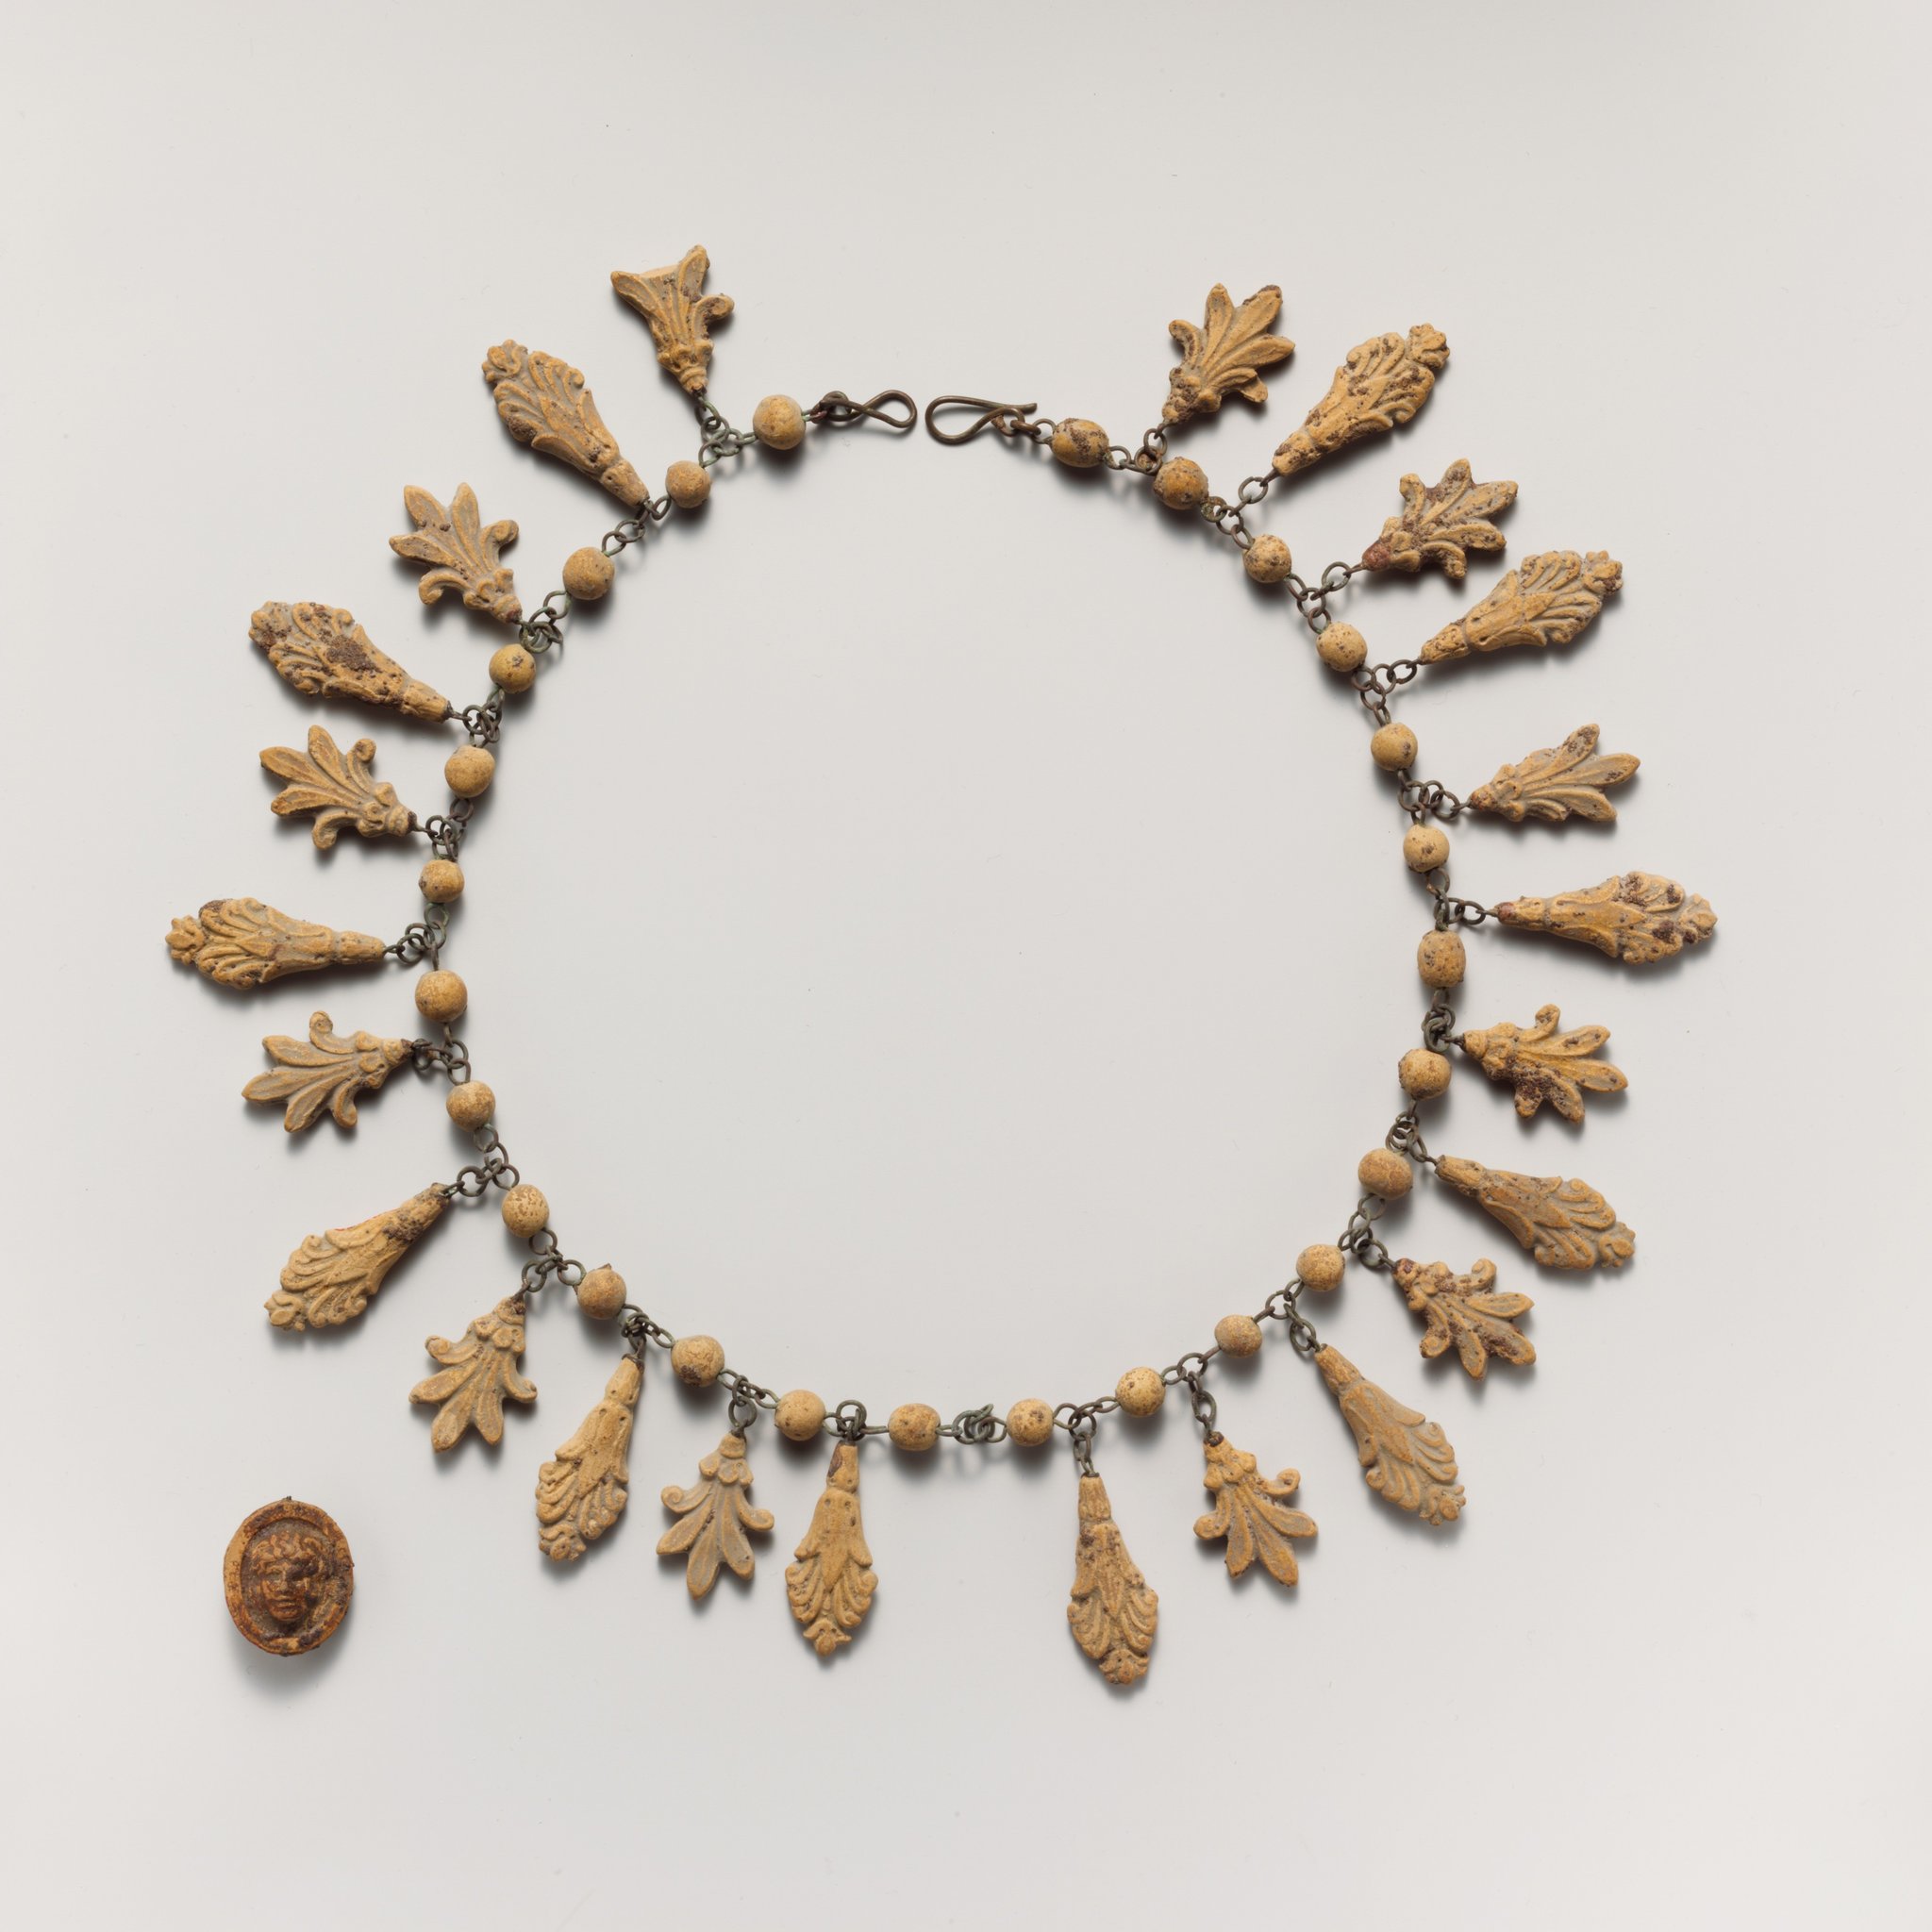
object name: necklace with 26 bead, 25 pendant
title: Terracotta necklace with palmette and lotus pendants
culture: etruscan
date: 300-201 BCE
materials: terracotta